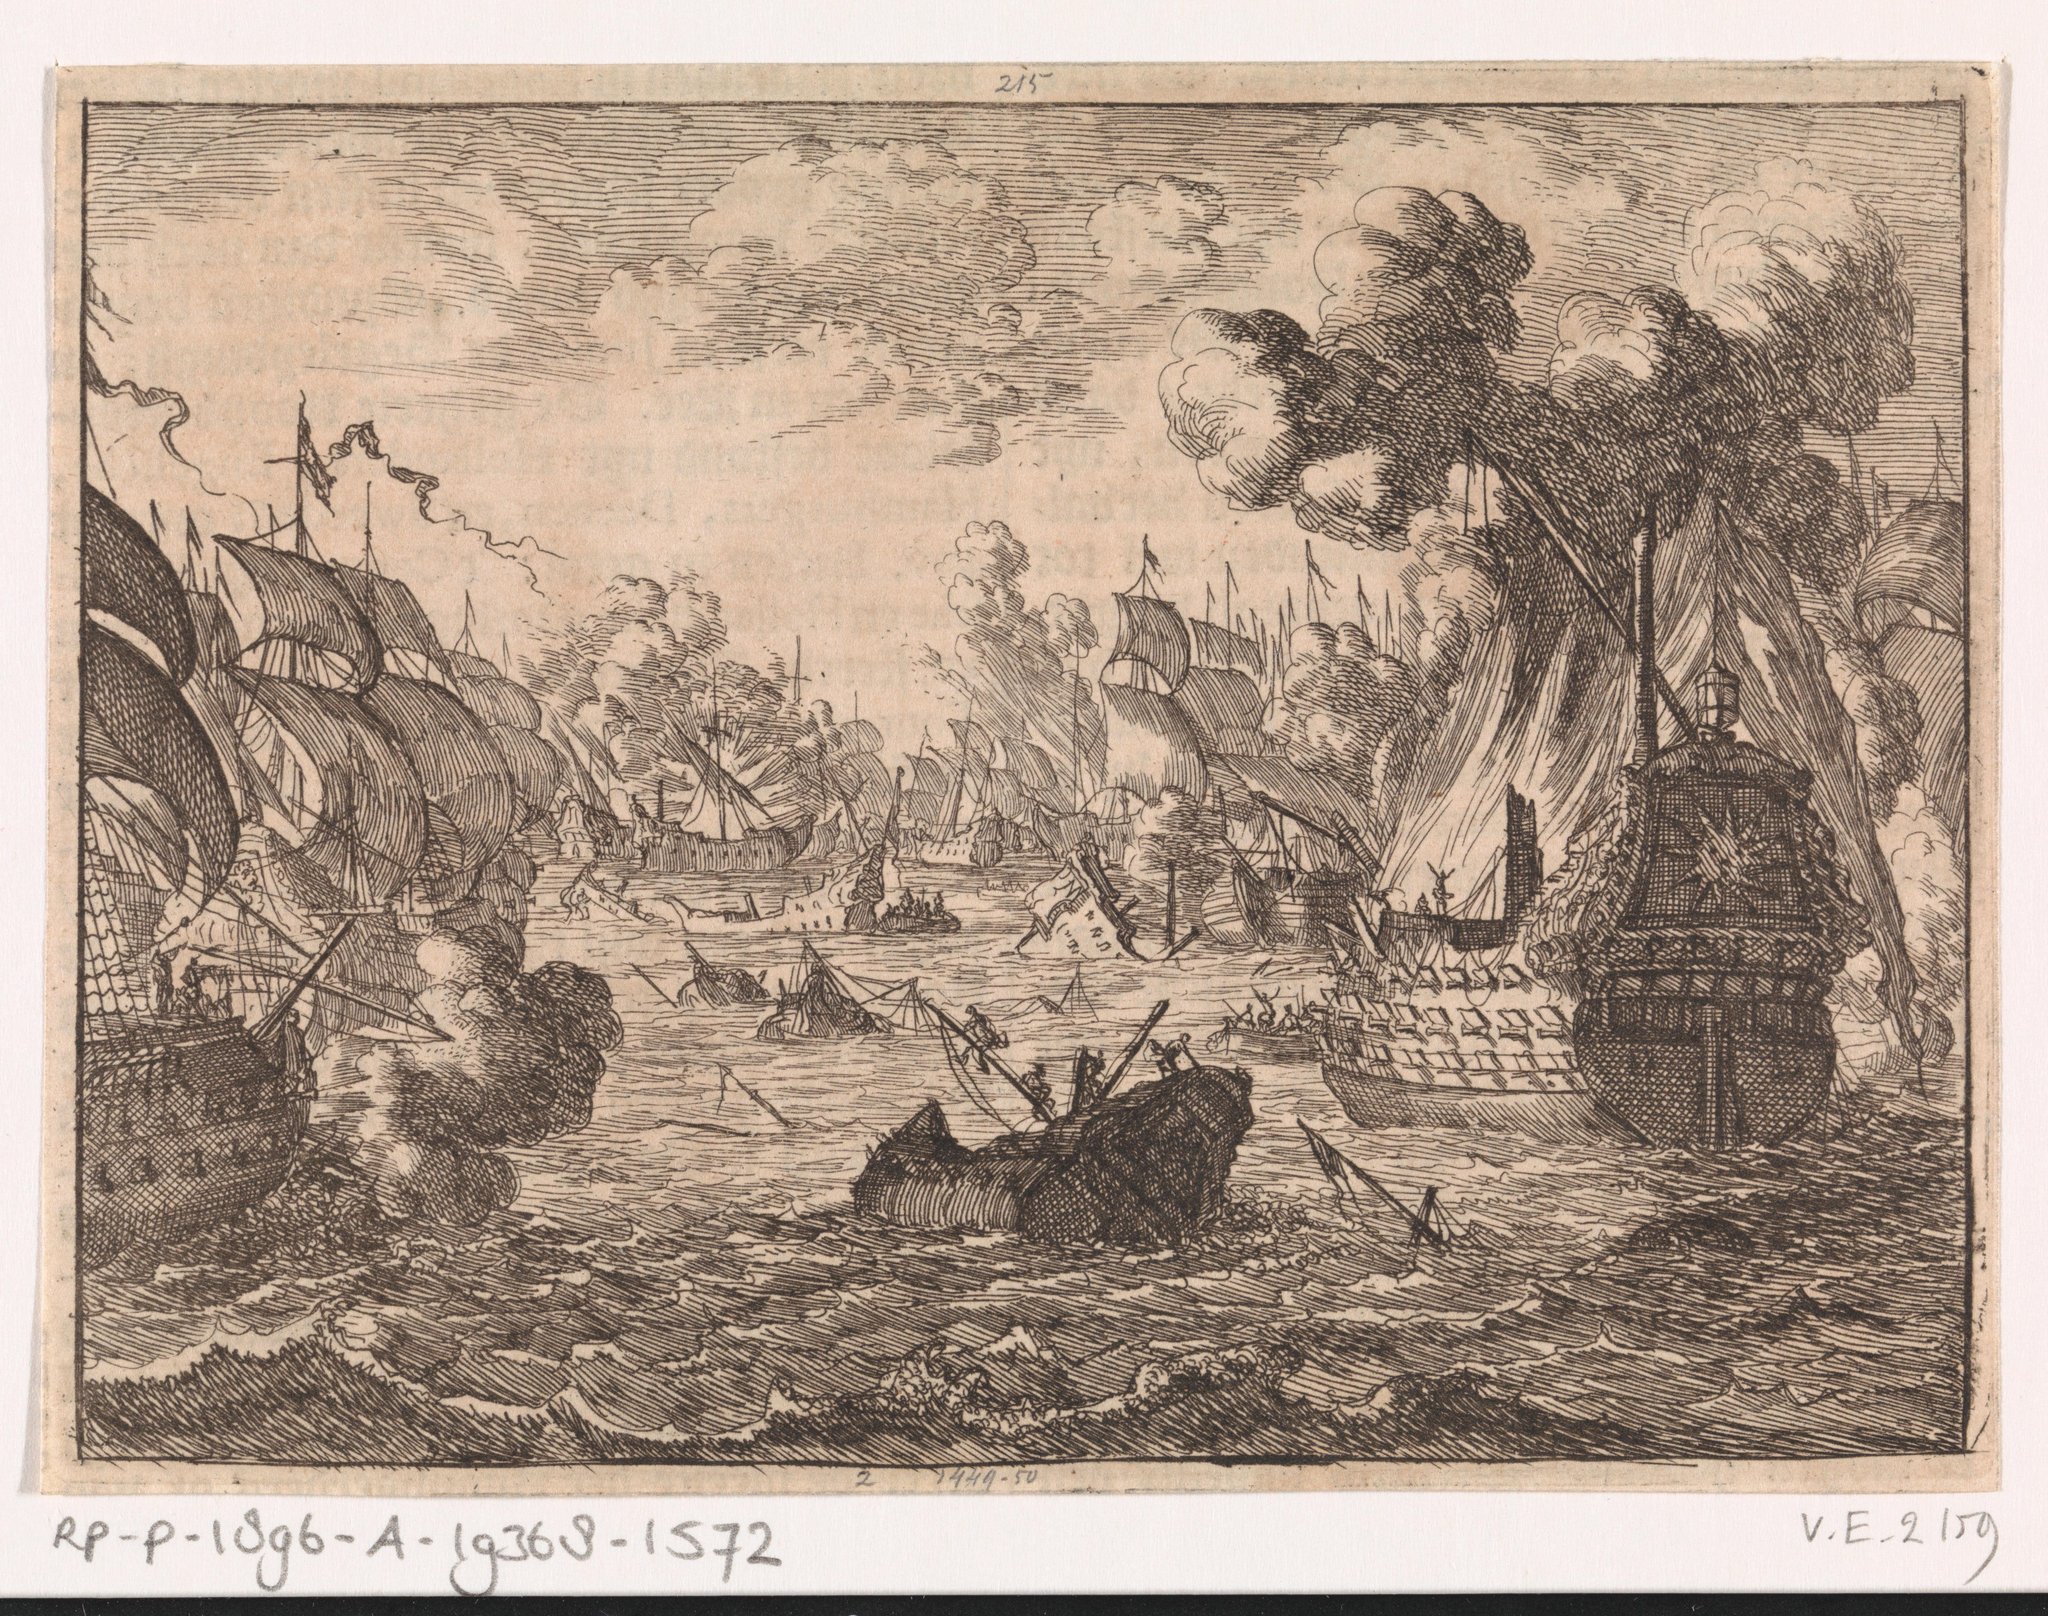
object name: print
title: Zeeslag bij Kaap La Hogue, 1692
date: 1698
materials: paper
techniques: etching, letterpress printing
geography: amsterdam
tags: paris, battle (+ naval force)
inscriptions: collector's mark: Lugt 2228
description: Illustratie uit: Gottfried, Johann Ludwig. Historische kronyck; vervattende een (...) beschrijvingh der aldergedenckwaerdigste geschiedenissen des weerelds, van den aenvangh der scheppingh tot (...) 1576 (2 delen). Leiden: Pieter van der Aa, 1698, dl. II, p. 1449.